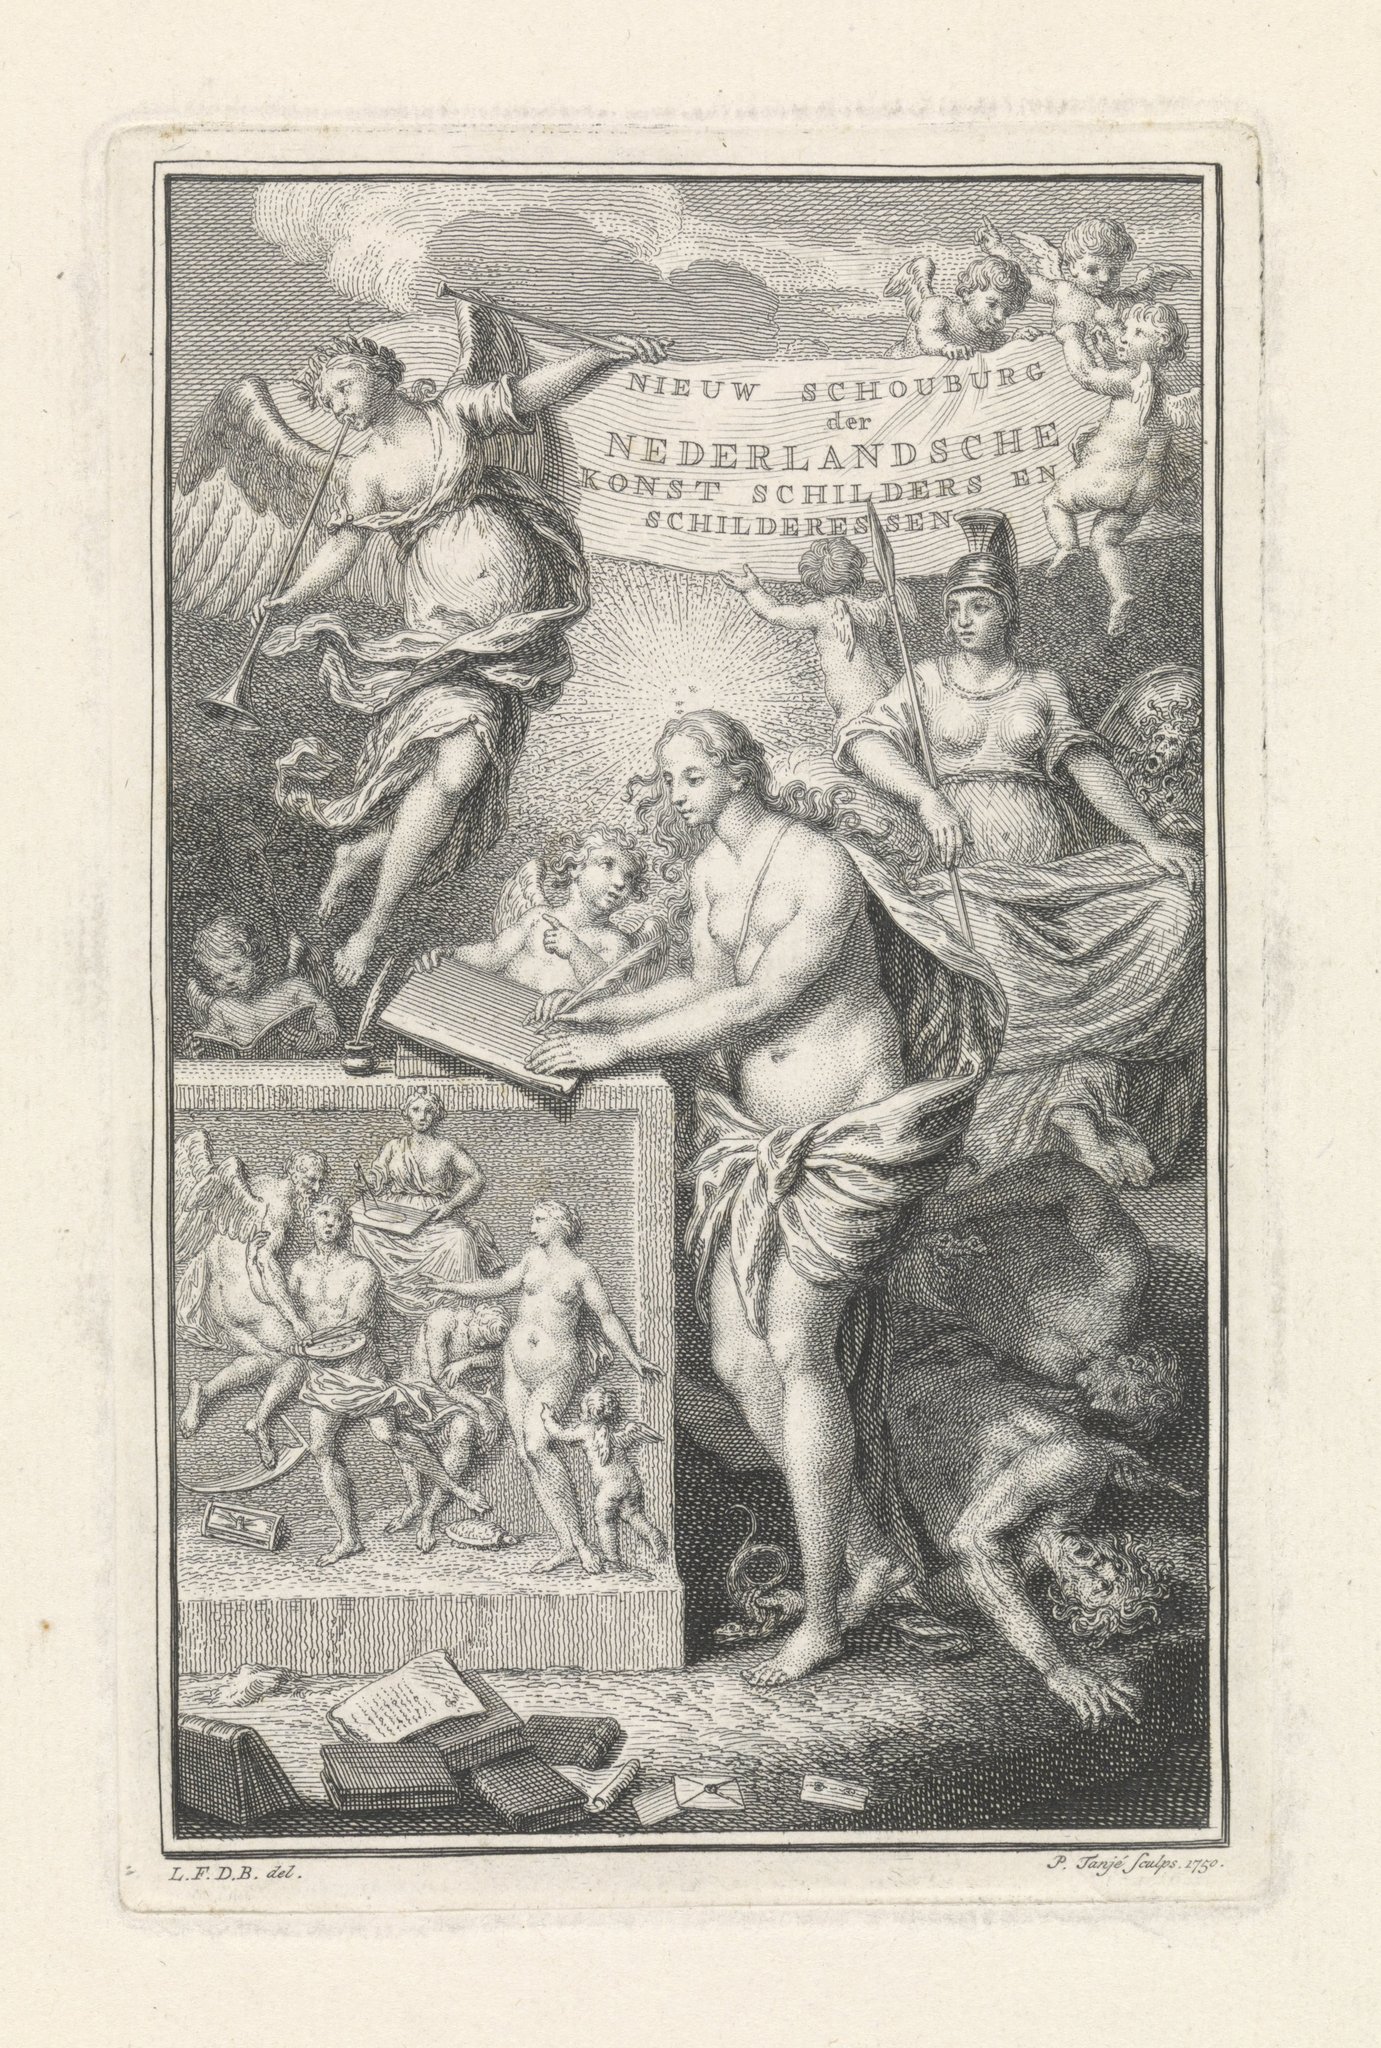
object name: print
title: Titelpagina voor: Johan van Gool, De nieuwe schouburg der Nederlantsche kunstschilders en schilderessen, 1750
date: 1750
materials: paper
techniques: engraving, etching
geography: amsterdam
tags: (story of) minerva (pallas, athena), truth; 'verità' (ripa), (story of) venus (aphrodite), fame; 'fama', 'fama buona', 'fama chiara' (ripa), father time, man with wings and scythe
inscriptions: collector's mark: Lugt 240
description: De Waarheid, een vrouw met een zon boven haar hoofd, beschrijft de levens en daden van Nederlandse schilders en vertrapt de Nijd en de Luiheid. Minerva, de god van de wijsheid, staat haar bij. Faam blaast de loftrompet. Het stenen reliëf toont een schilder, die belaagd wordt door Vader Tijd en de slapende Luiheid. Daarbij staan Venus als de Schoonheid en de Meetkunde om hem tot het maken van goede kunst aan te moedigen.